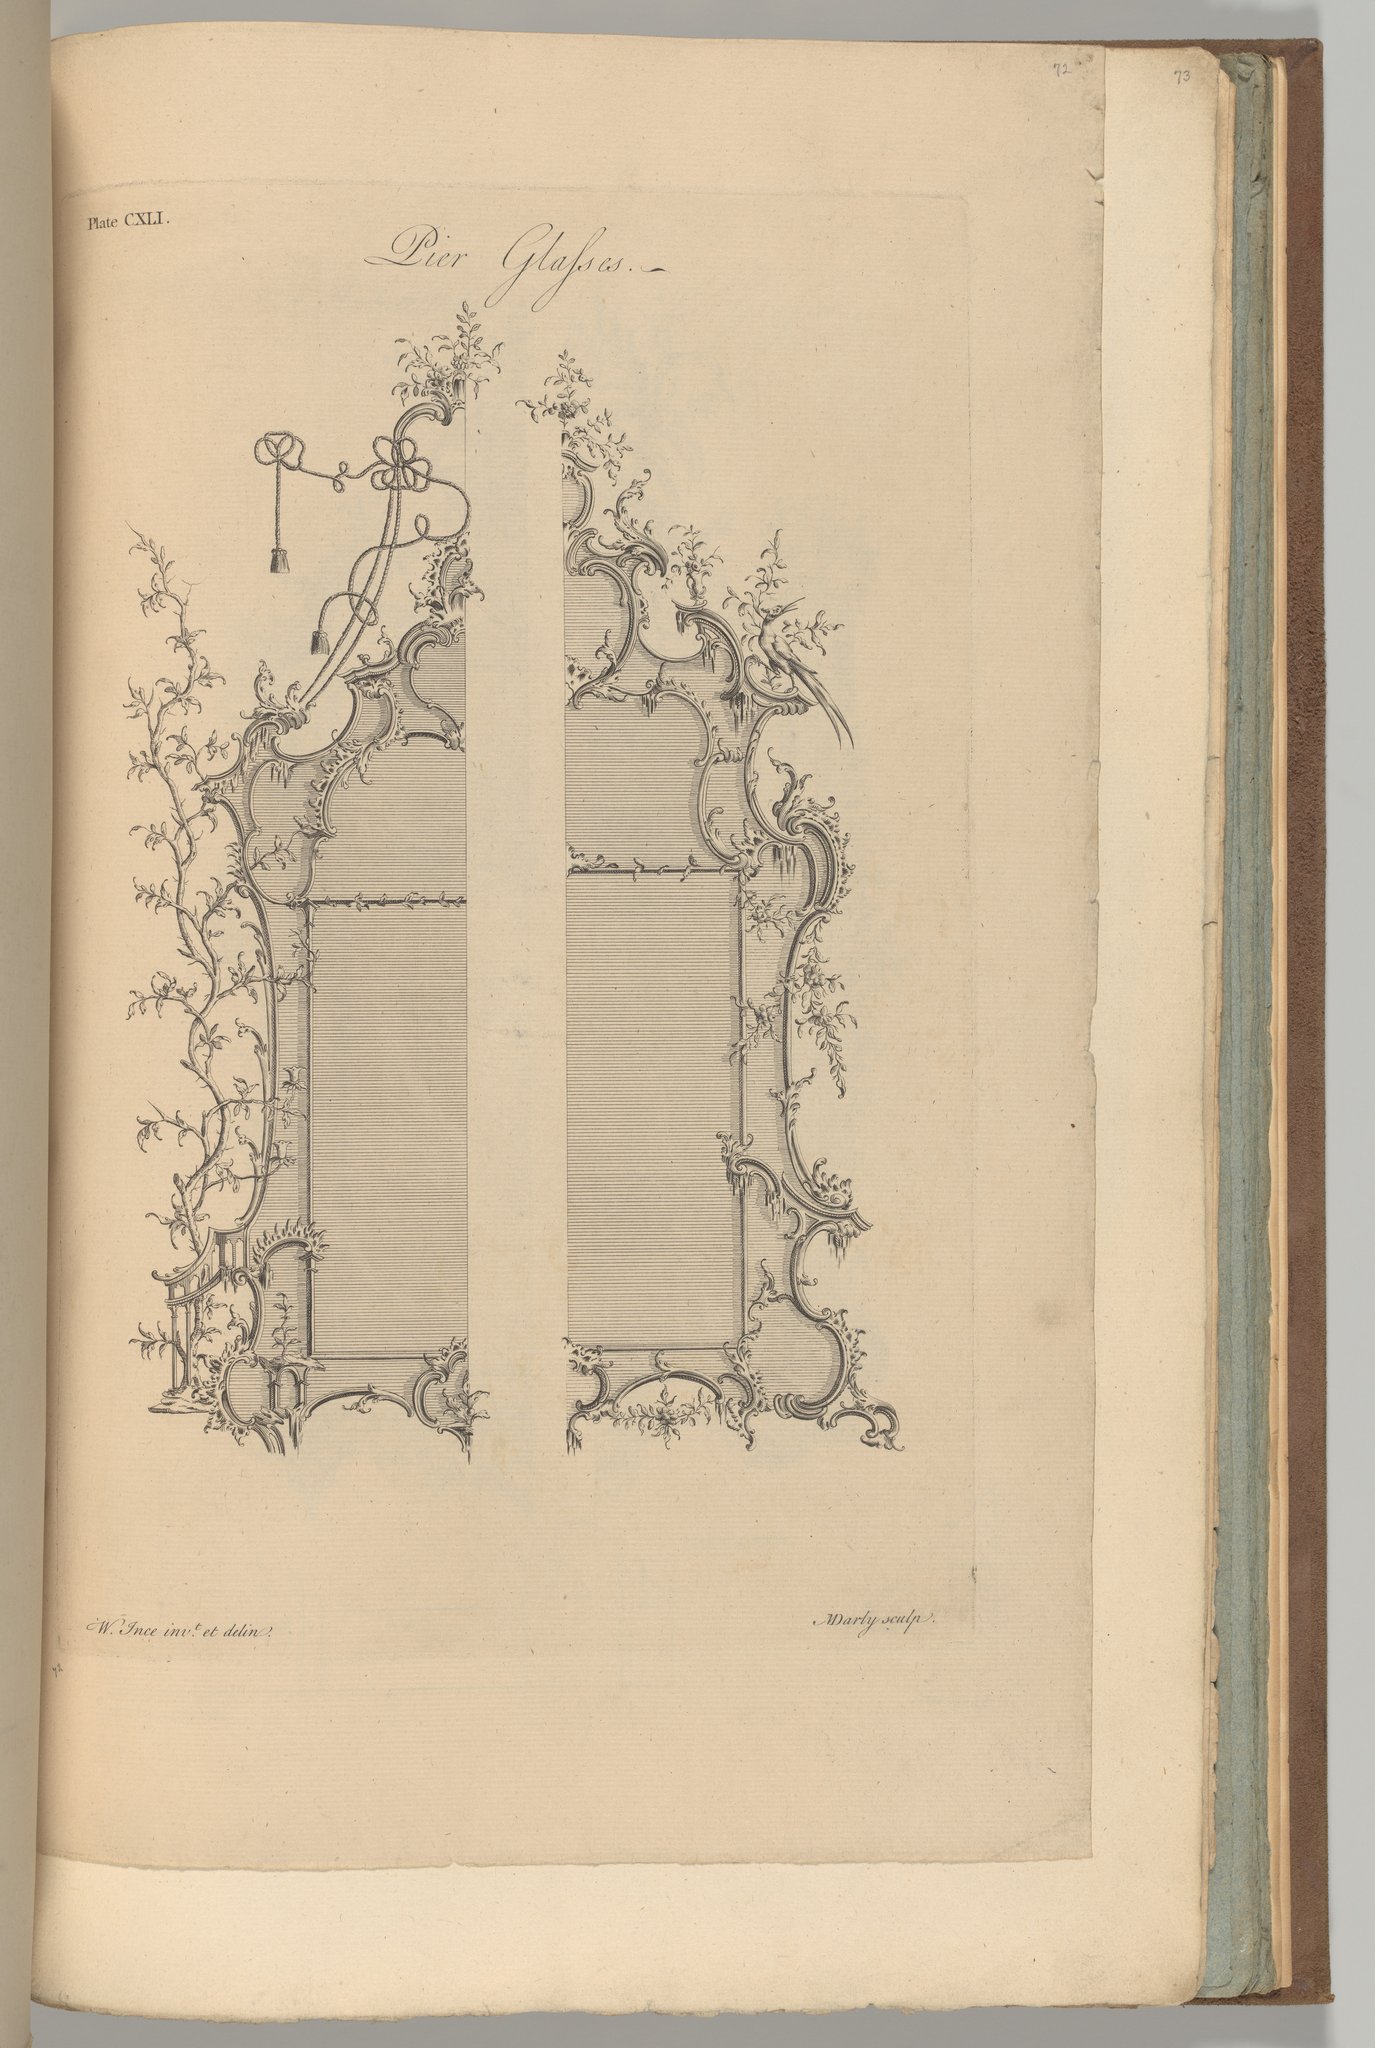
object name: book print ornament architecture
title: A General System of Useful and Ornamental Furniture...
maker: ince and mayhew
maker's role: author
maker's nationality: british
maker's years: 1758-1811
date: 1759-1763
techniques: engraving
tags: furniture